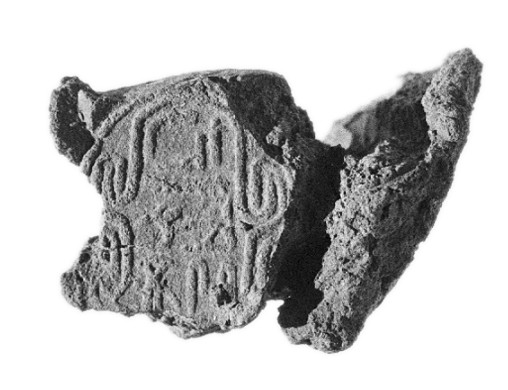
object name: sealing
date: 1981-1640 BCE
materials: mud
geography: egypt